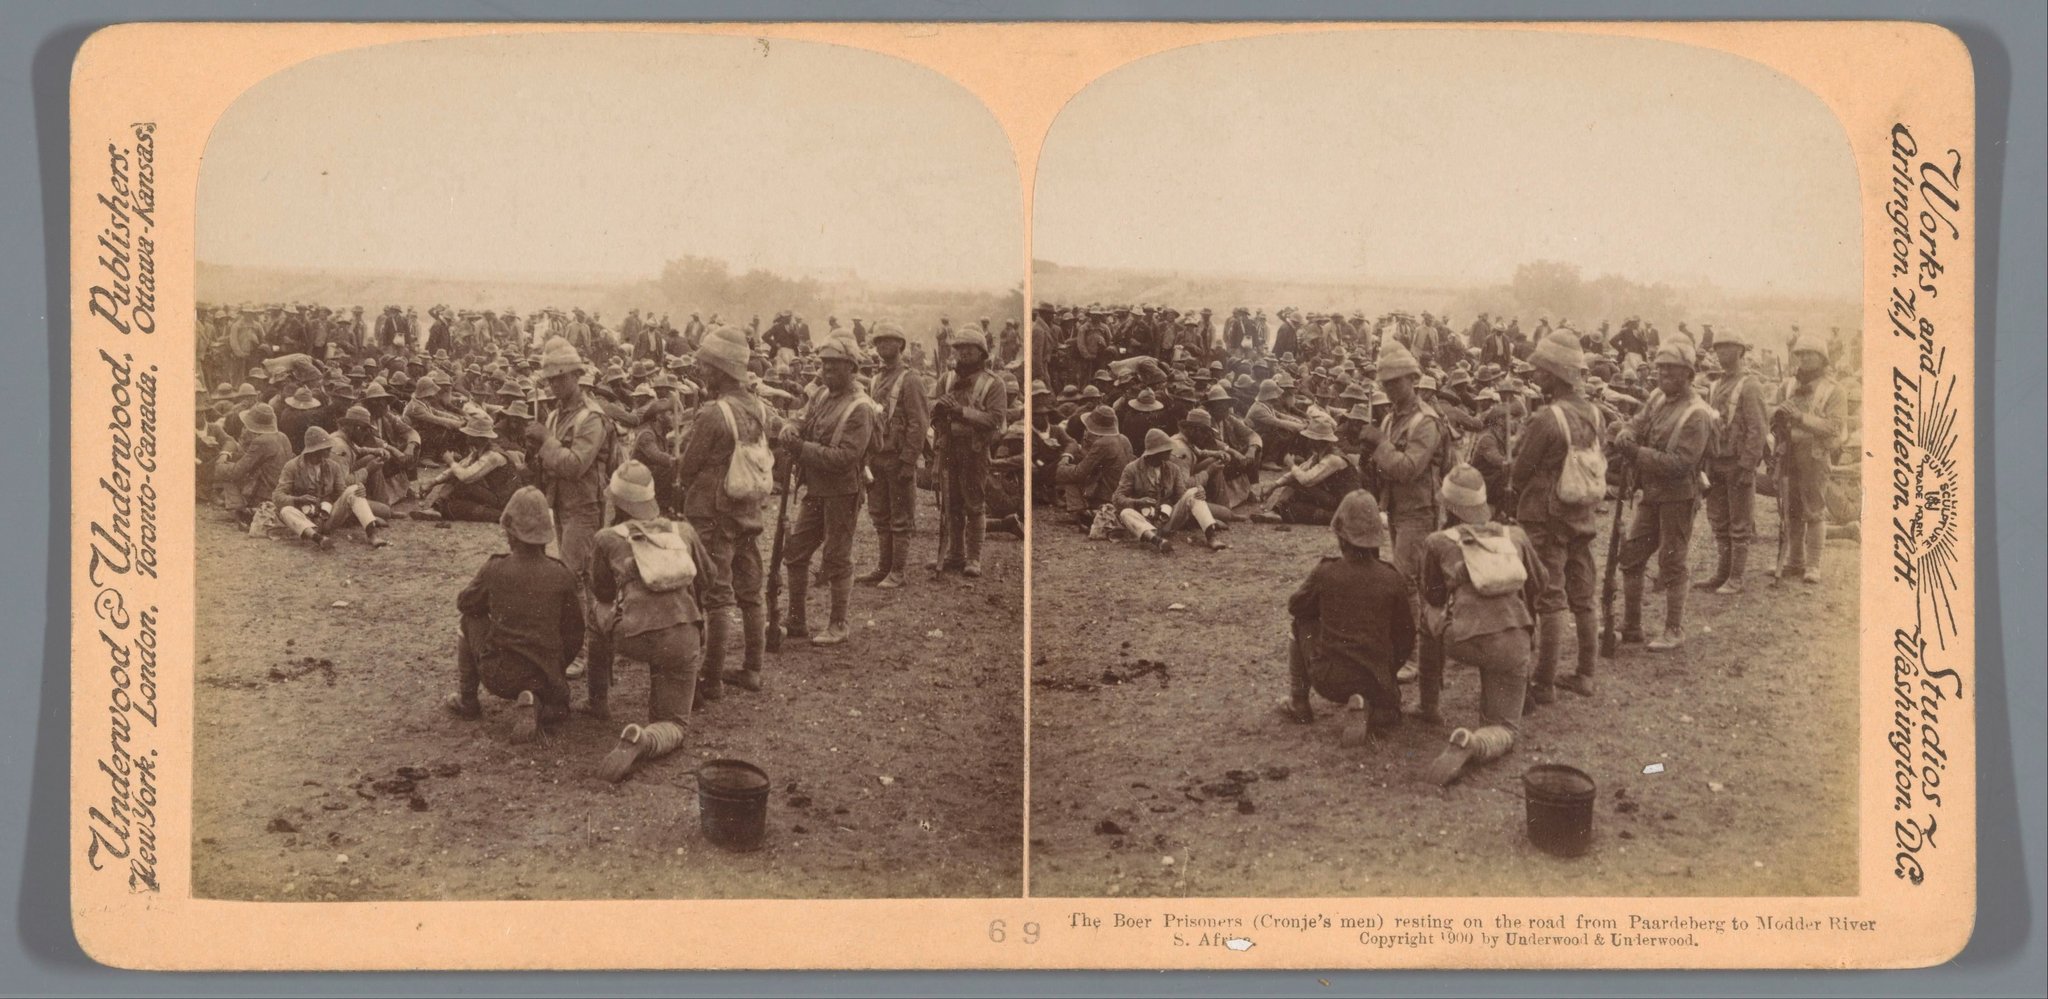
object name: stereograph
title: Boerenkrijgsgevangenen rusten uit op de weg tussen Paardeberg en de Modderrivier, Zuid-Afrika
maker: Anonymous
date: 1900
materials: cardboard, paper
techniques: albumen print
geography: modderrivier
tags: prisoner of war (after the battle)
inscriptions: inscription, number: ‘69’, copyright notice: ‘Copyright 1900 by Underwood & Underwood.’, inscription: ‘Works and Studios ~/ Arlington, N.J. Littleton, N.H. Washington, D.C.’